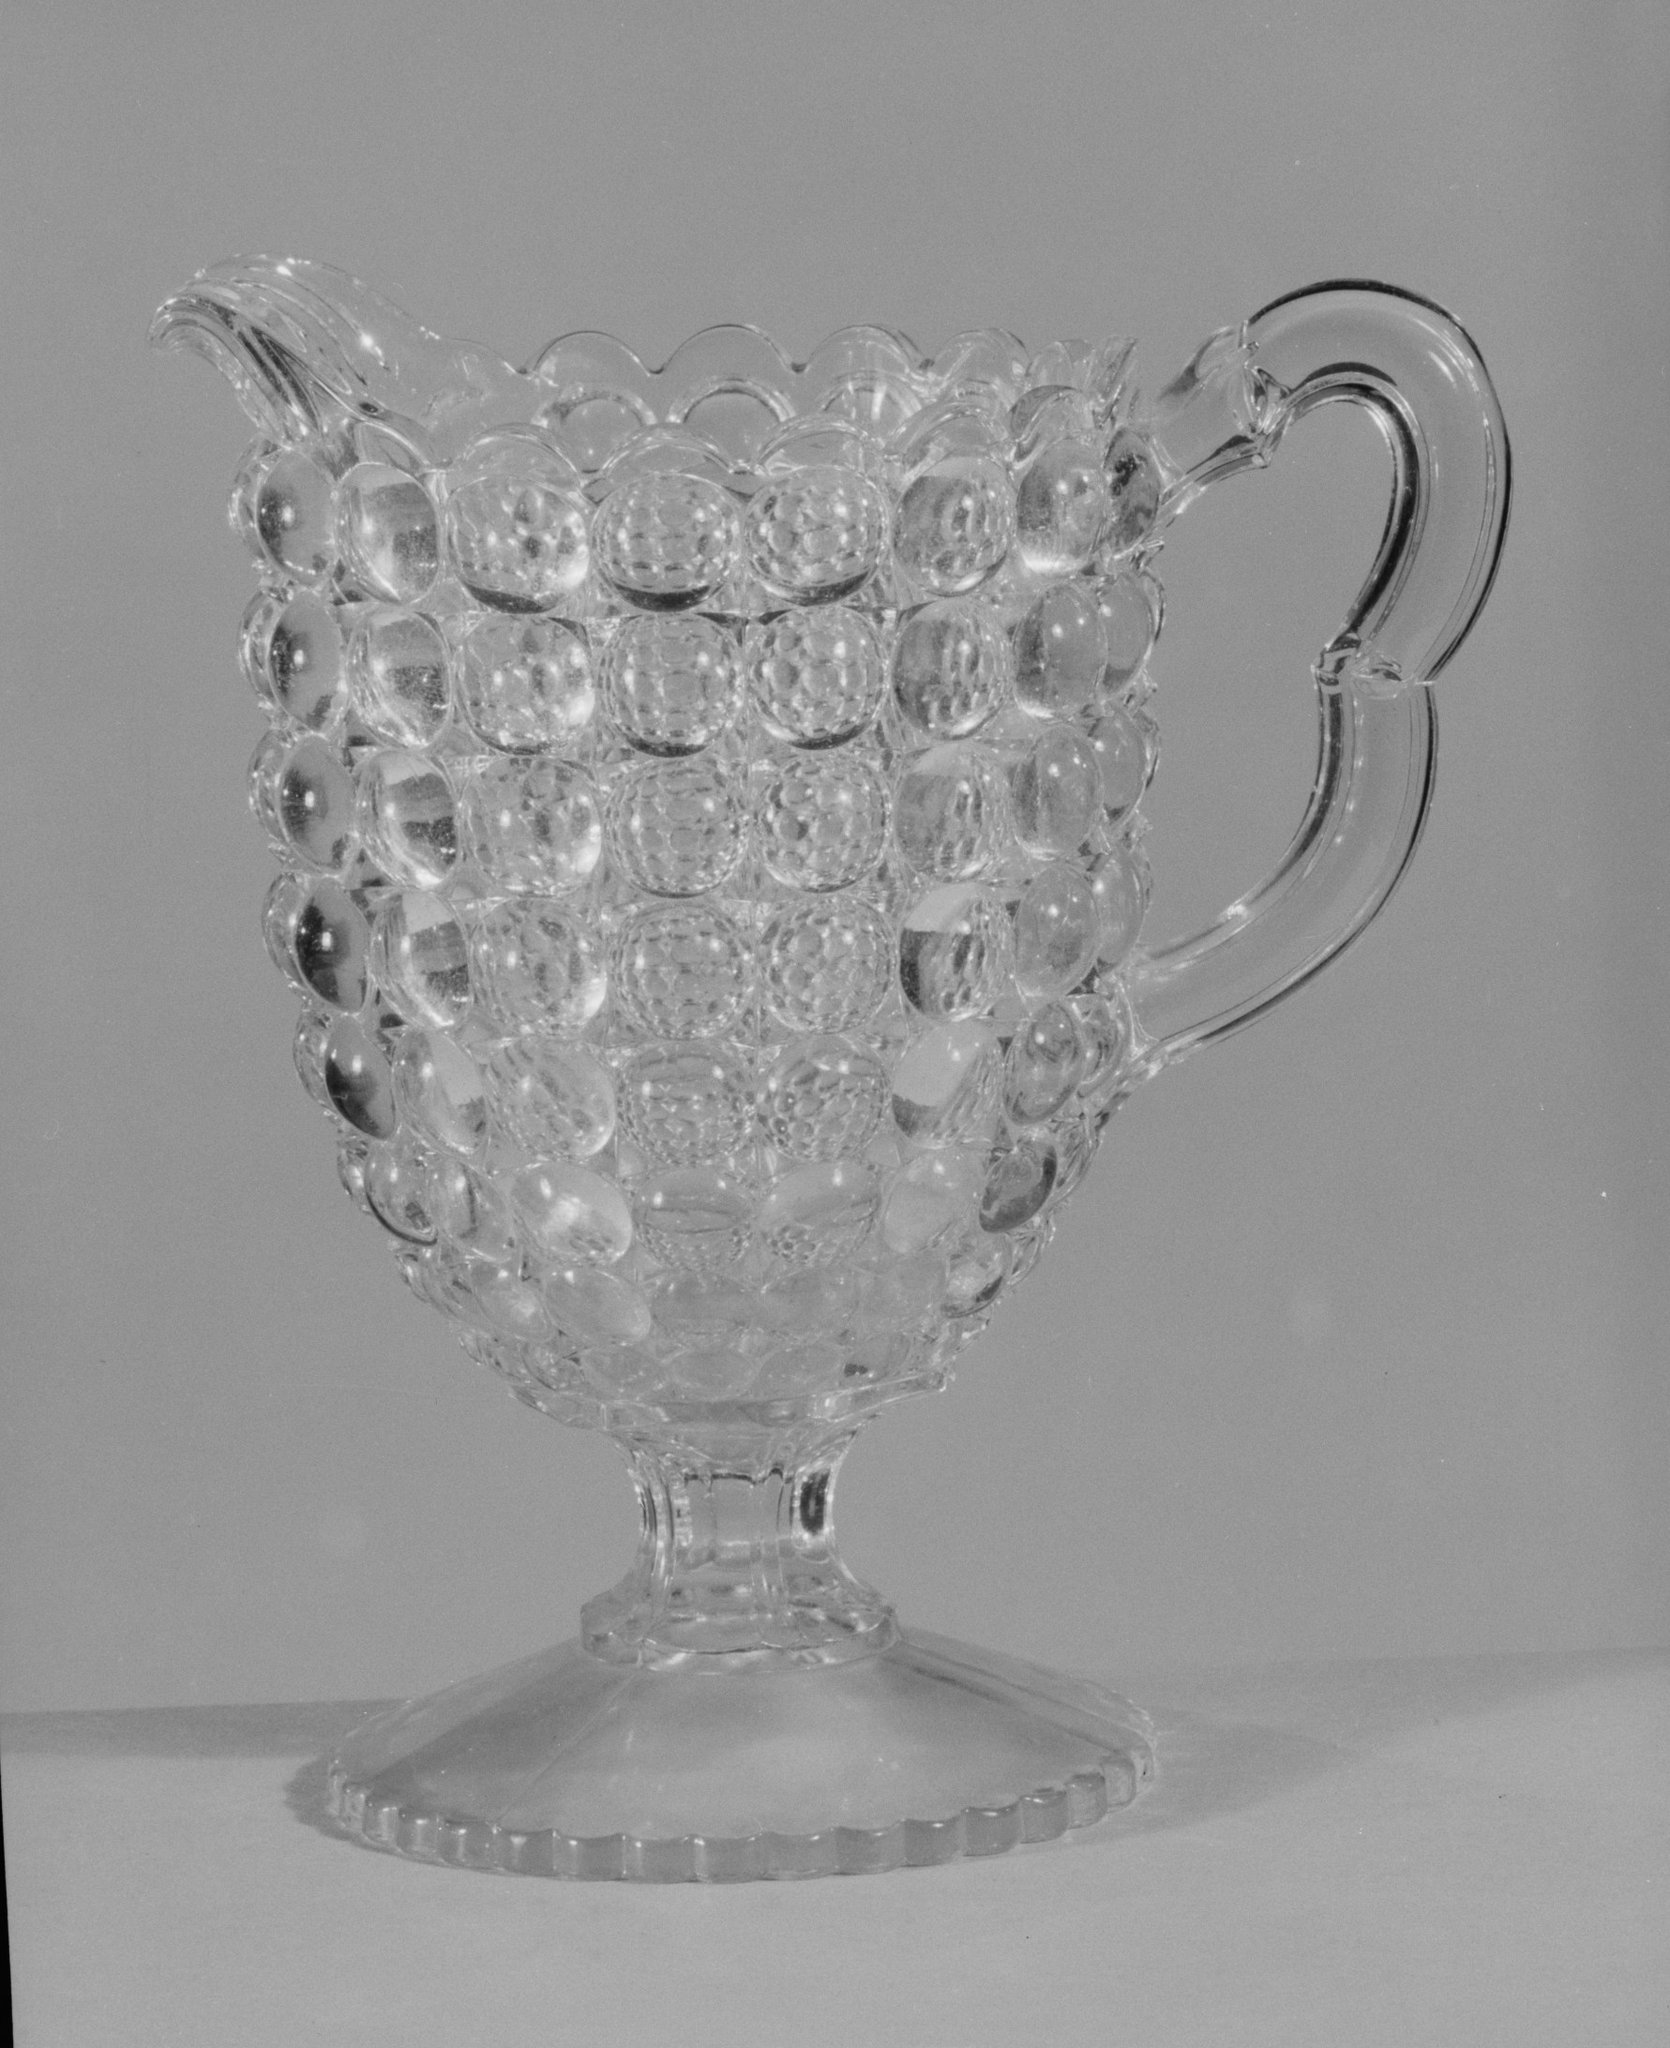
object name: cream pot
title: Creamer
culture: american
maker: richards and hartley flint glass co.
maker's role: maker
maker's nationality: american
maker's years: 1867-1890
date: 1888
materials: glass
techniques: pressed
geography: united states